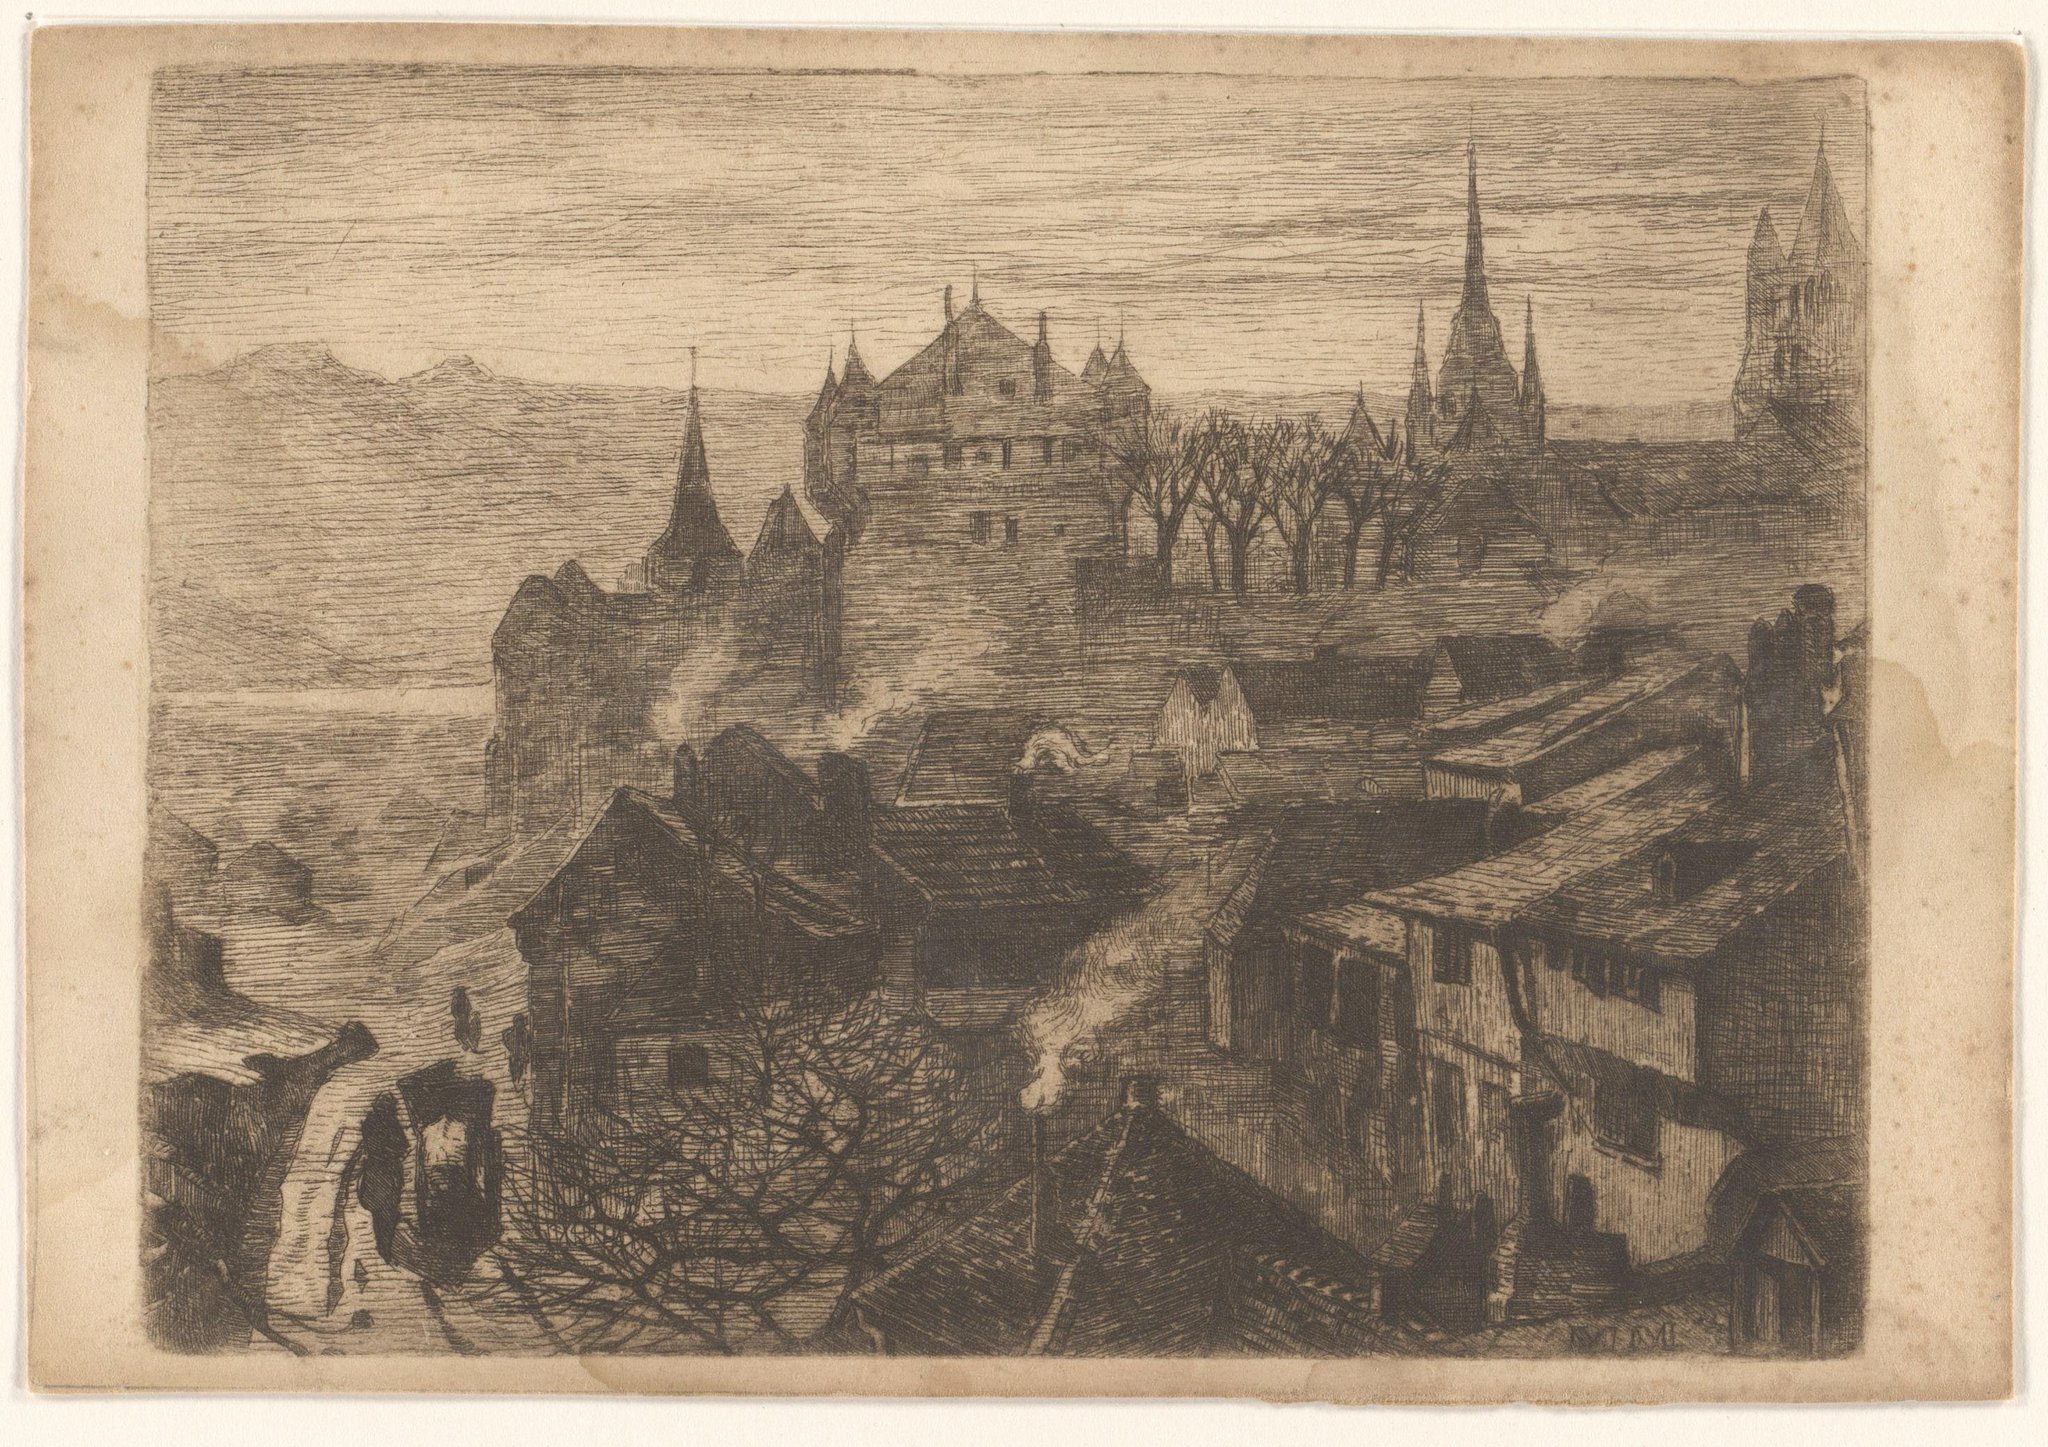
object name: print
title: Vue de Fribourg (Lausanne)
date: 1875-1890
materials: paper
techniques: etching, intaglio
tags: castle, parts of church exterior and annexes: spire, prospect of city, town panorama, silhouette of city, mist, fog, mountains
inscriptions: monogram: ‘MM’